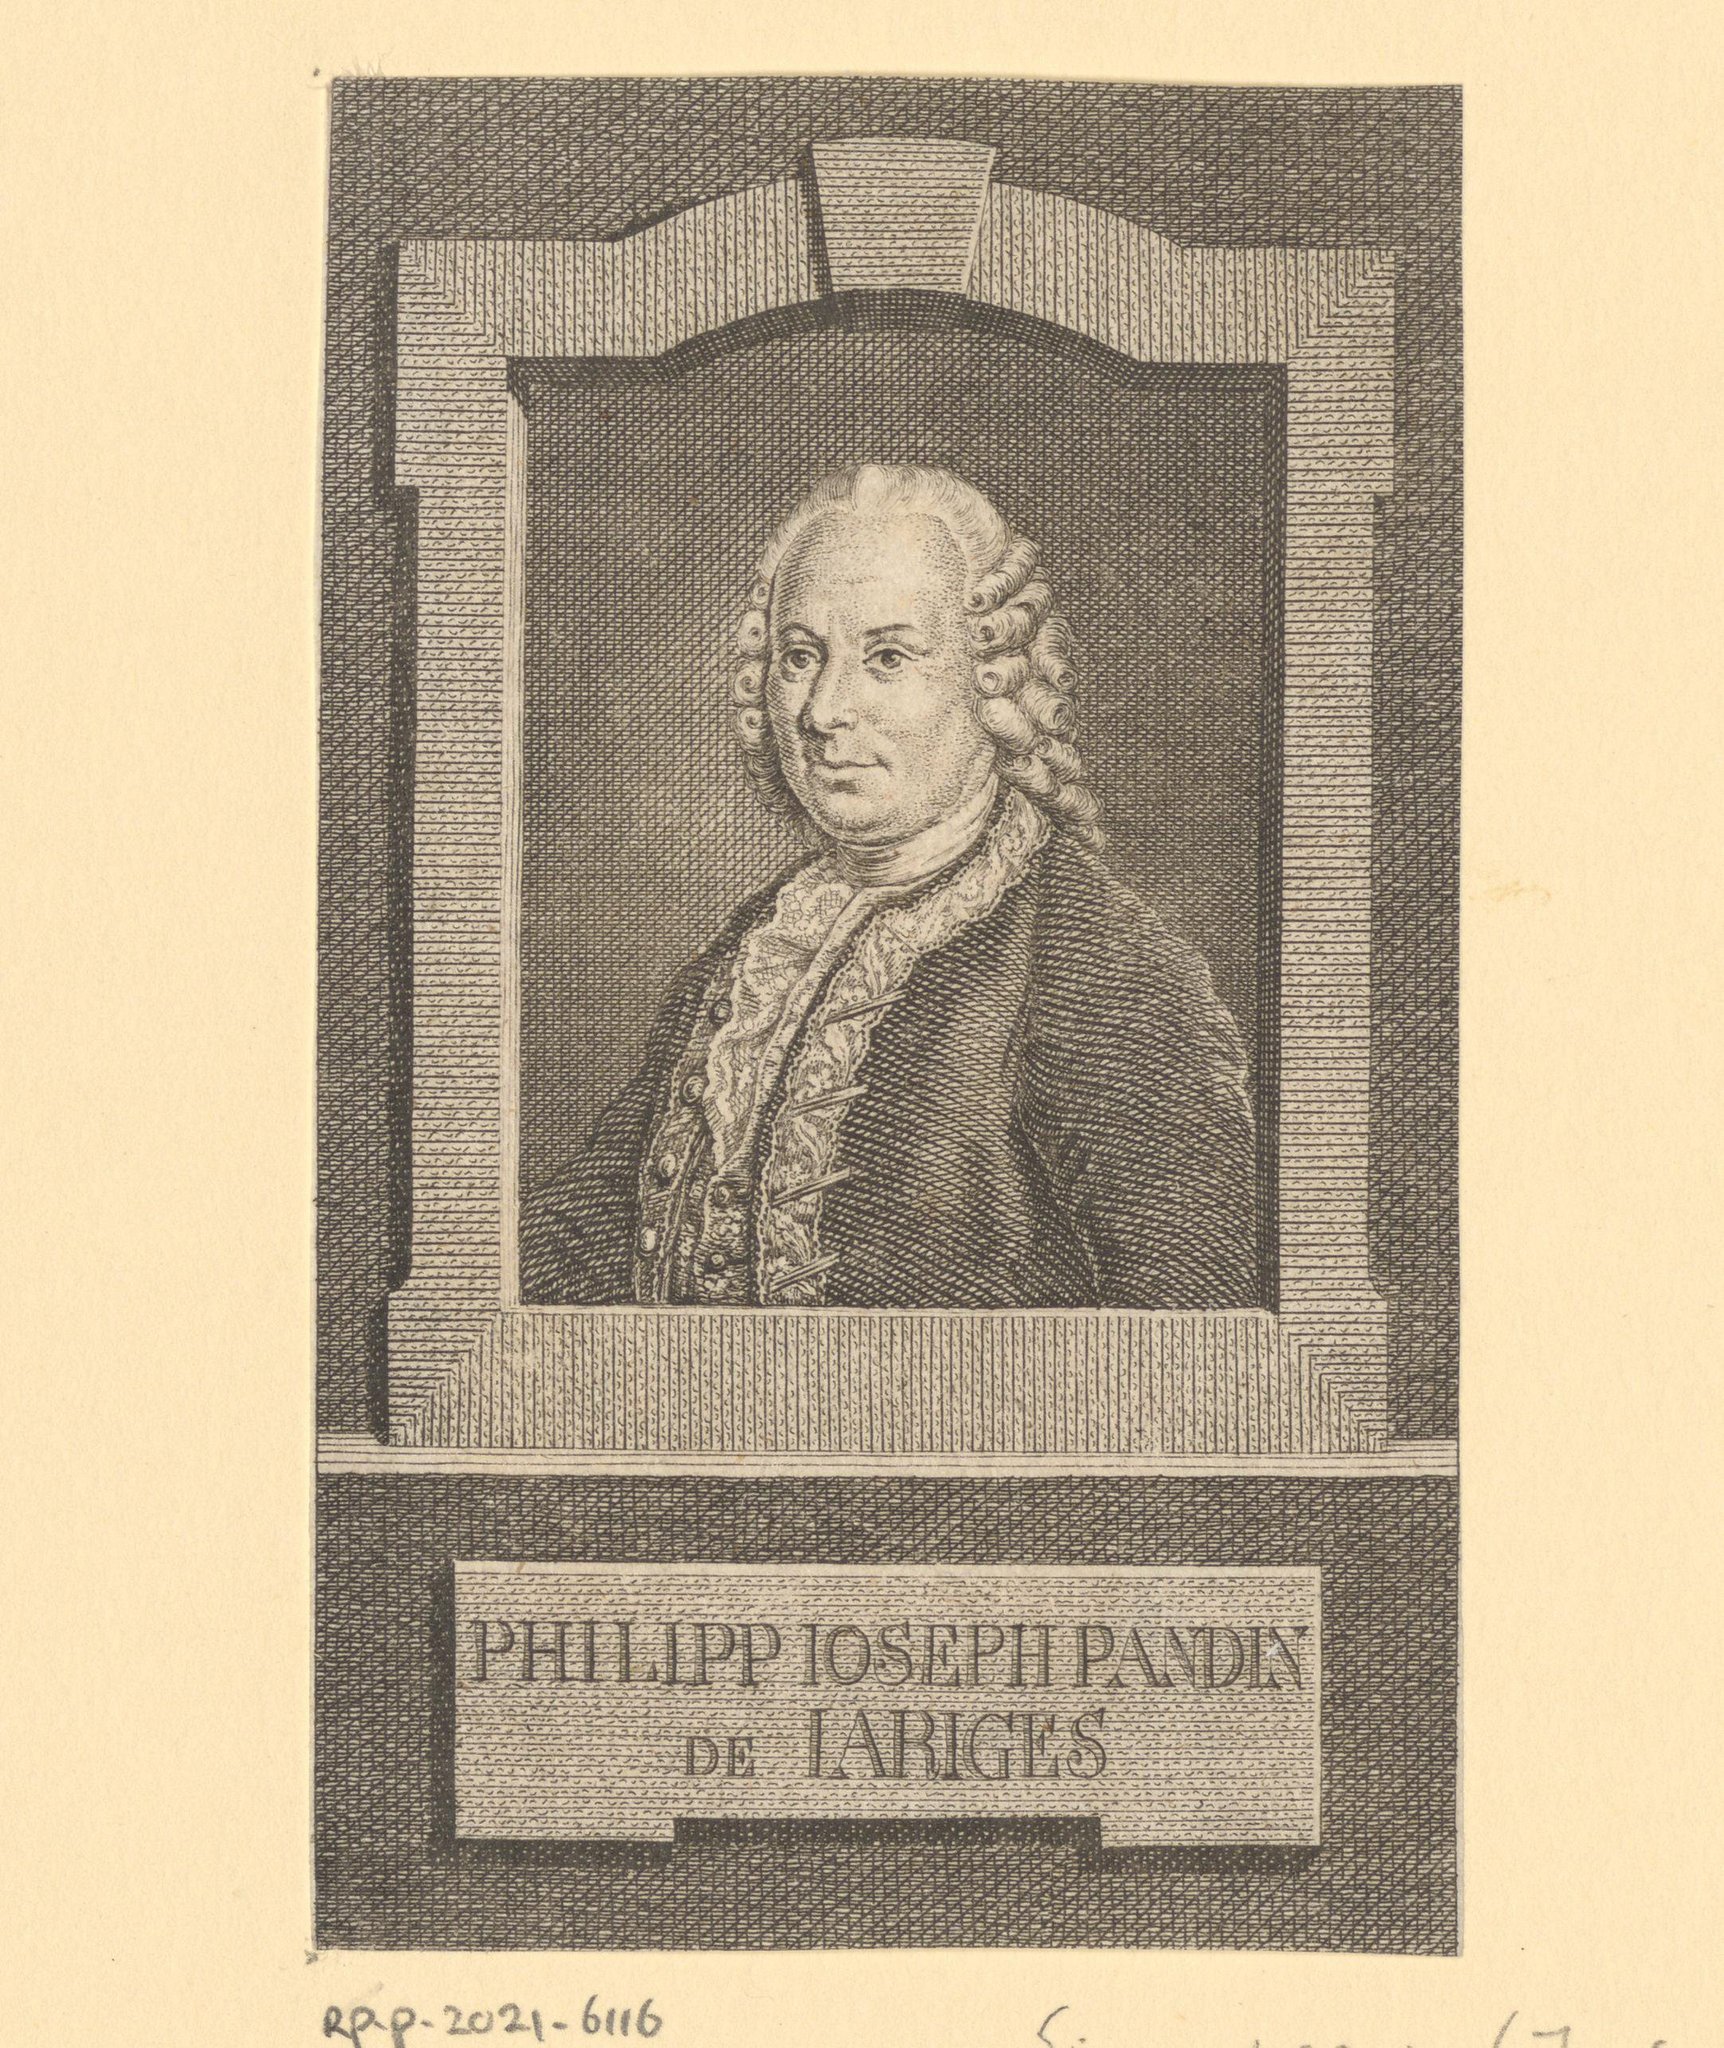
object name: print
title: Portret van Philipp Joseph Pandin von Jariges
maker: Anonymous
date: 1730-1799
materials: paper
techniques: engraving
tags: politician, adult man, historical persons